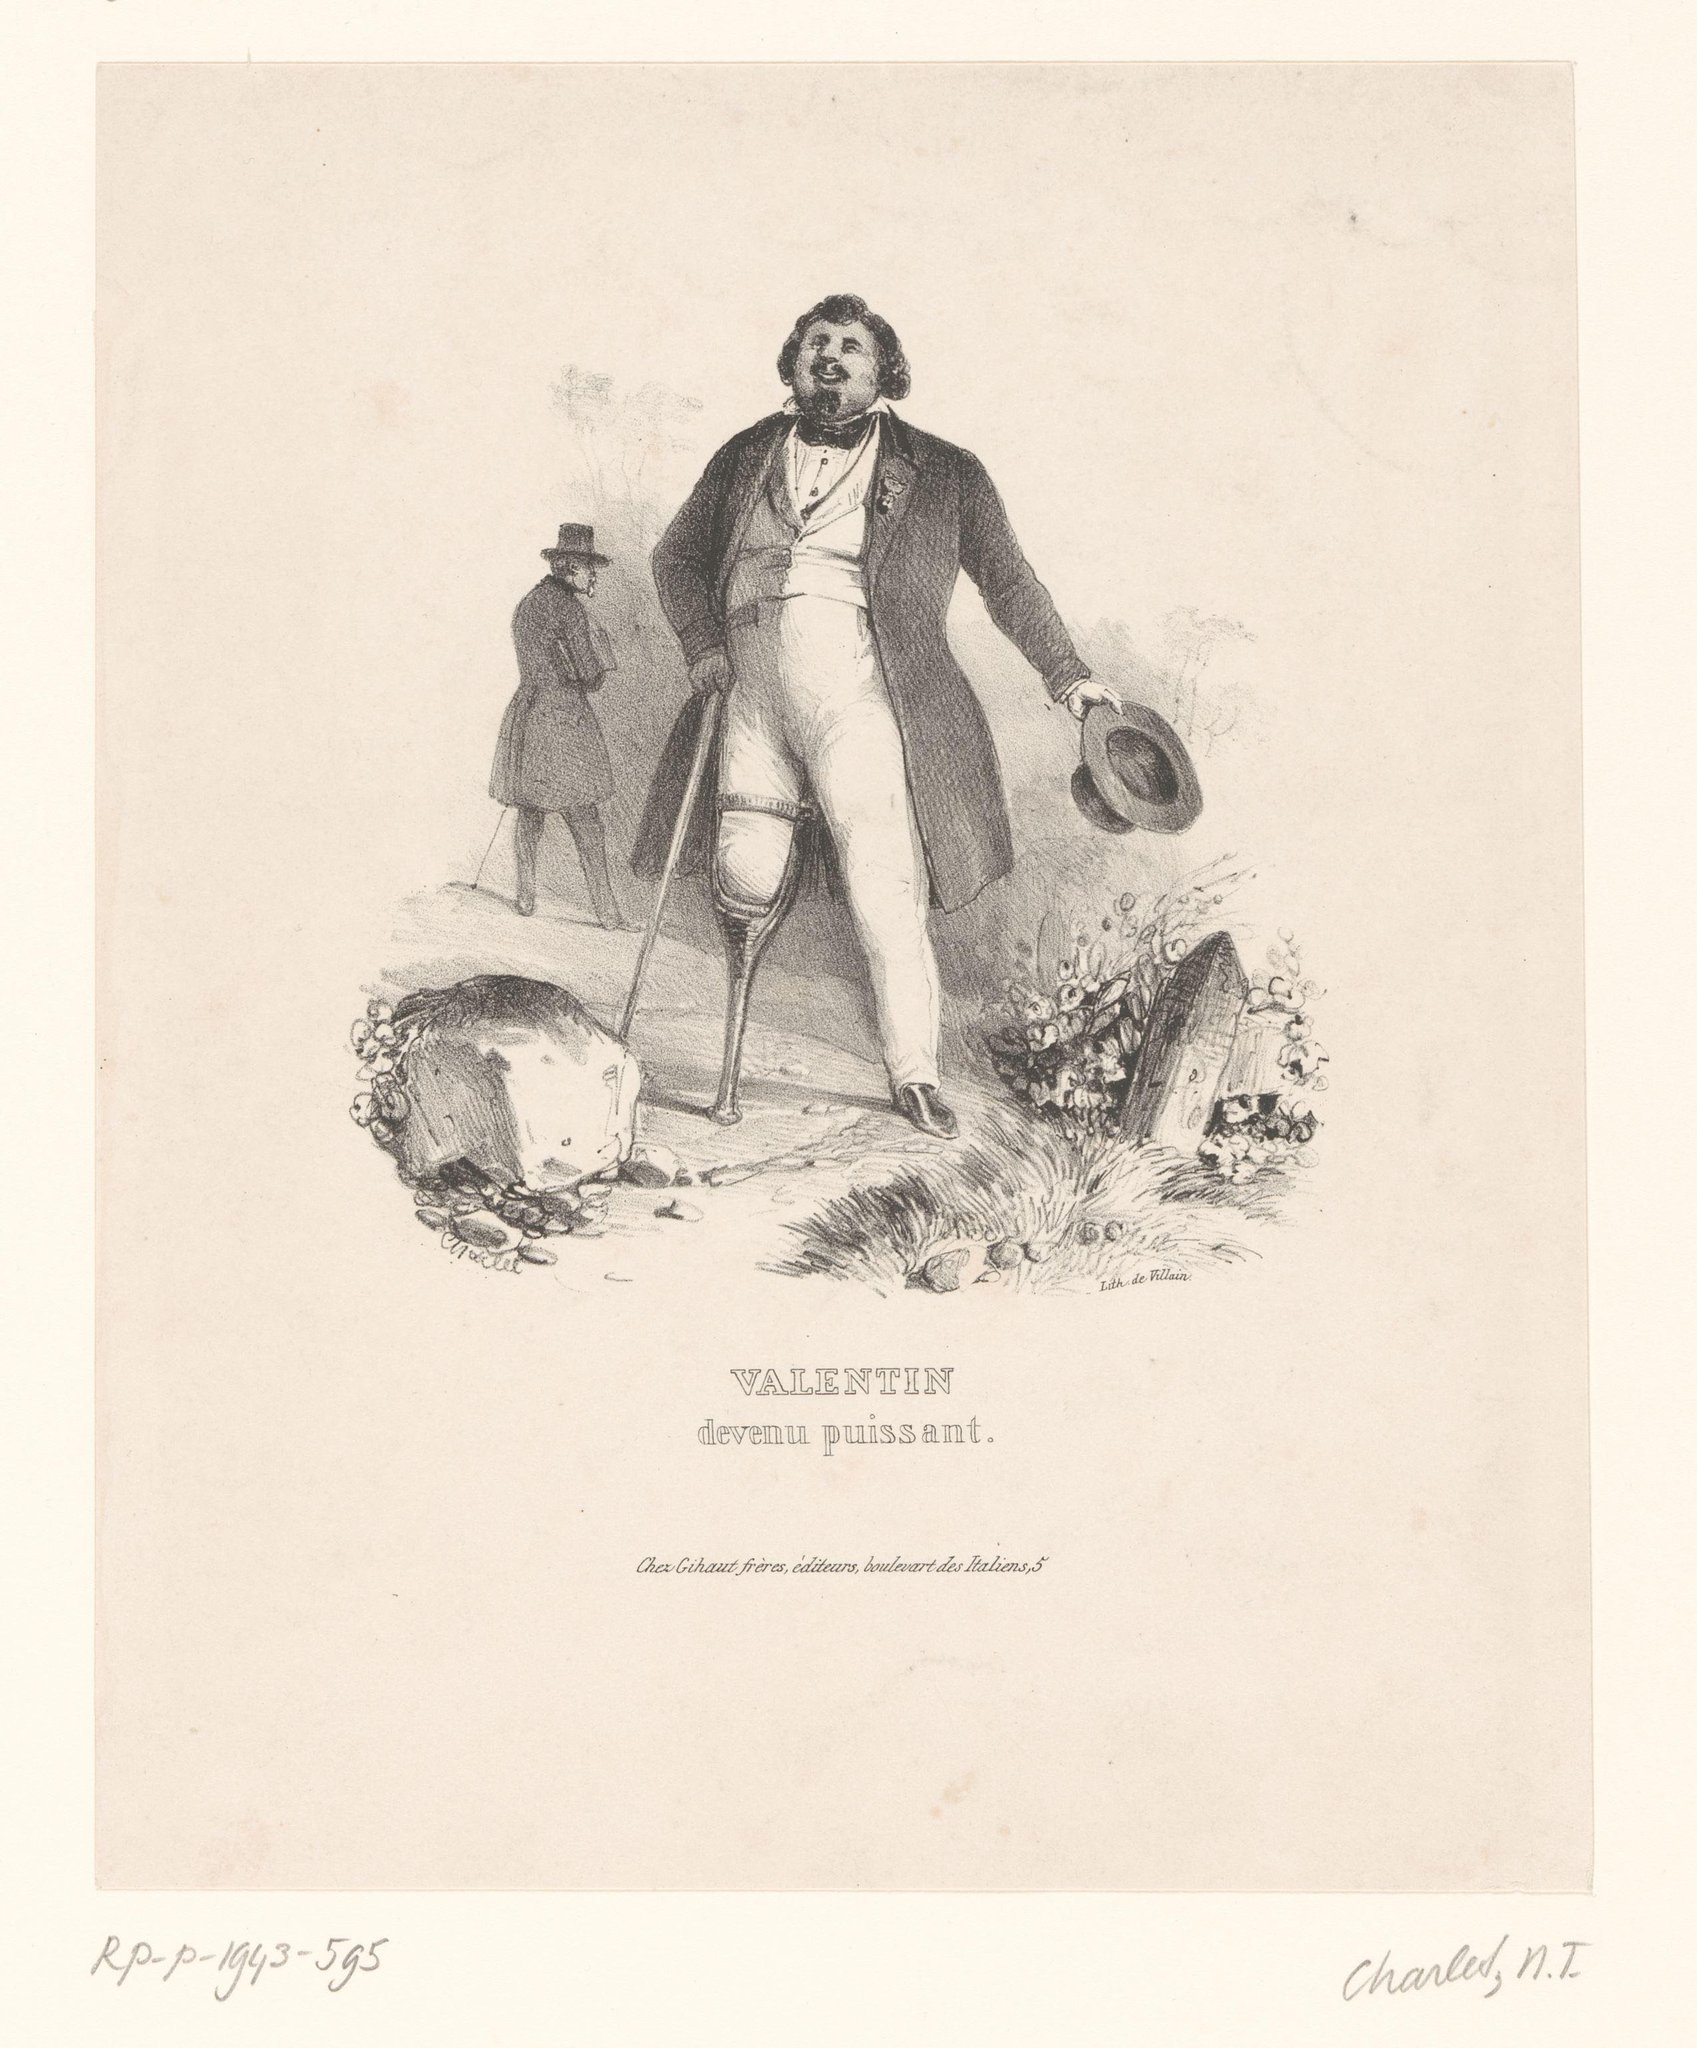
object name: print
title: Vie civile, politique et militaire du caporal Valentin (...)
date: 1837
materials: paper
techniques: lithograph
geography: paris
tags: disabled soldier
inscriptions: collector's mark: Lugt 2228a